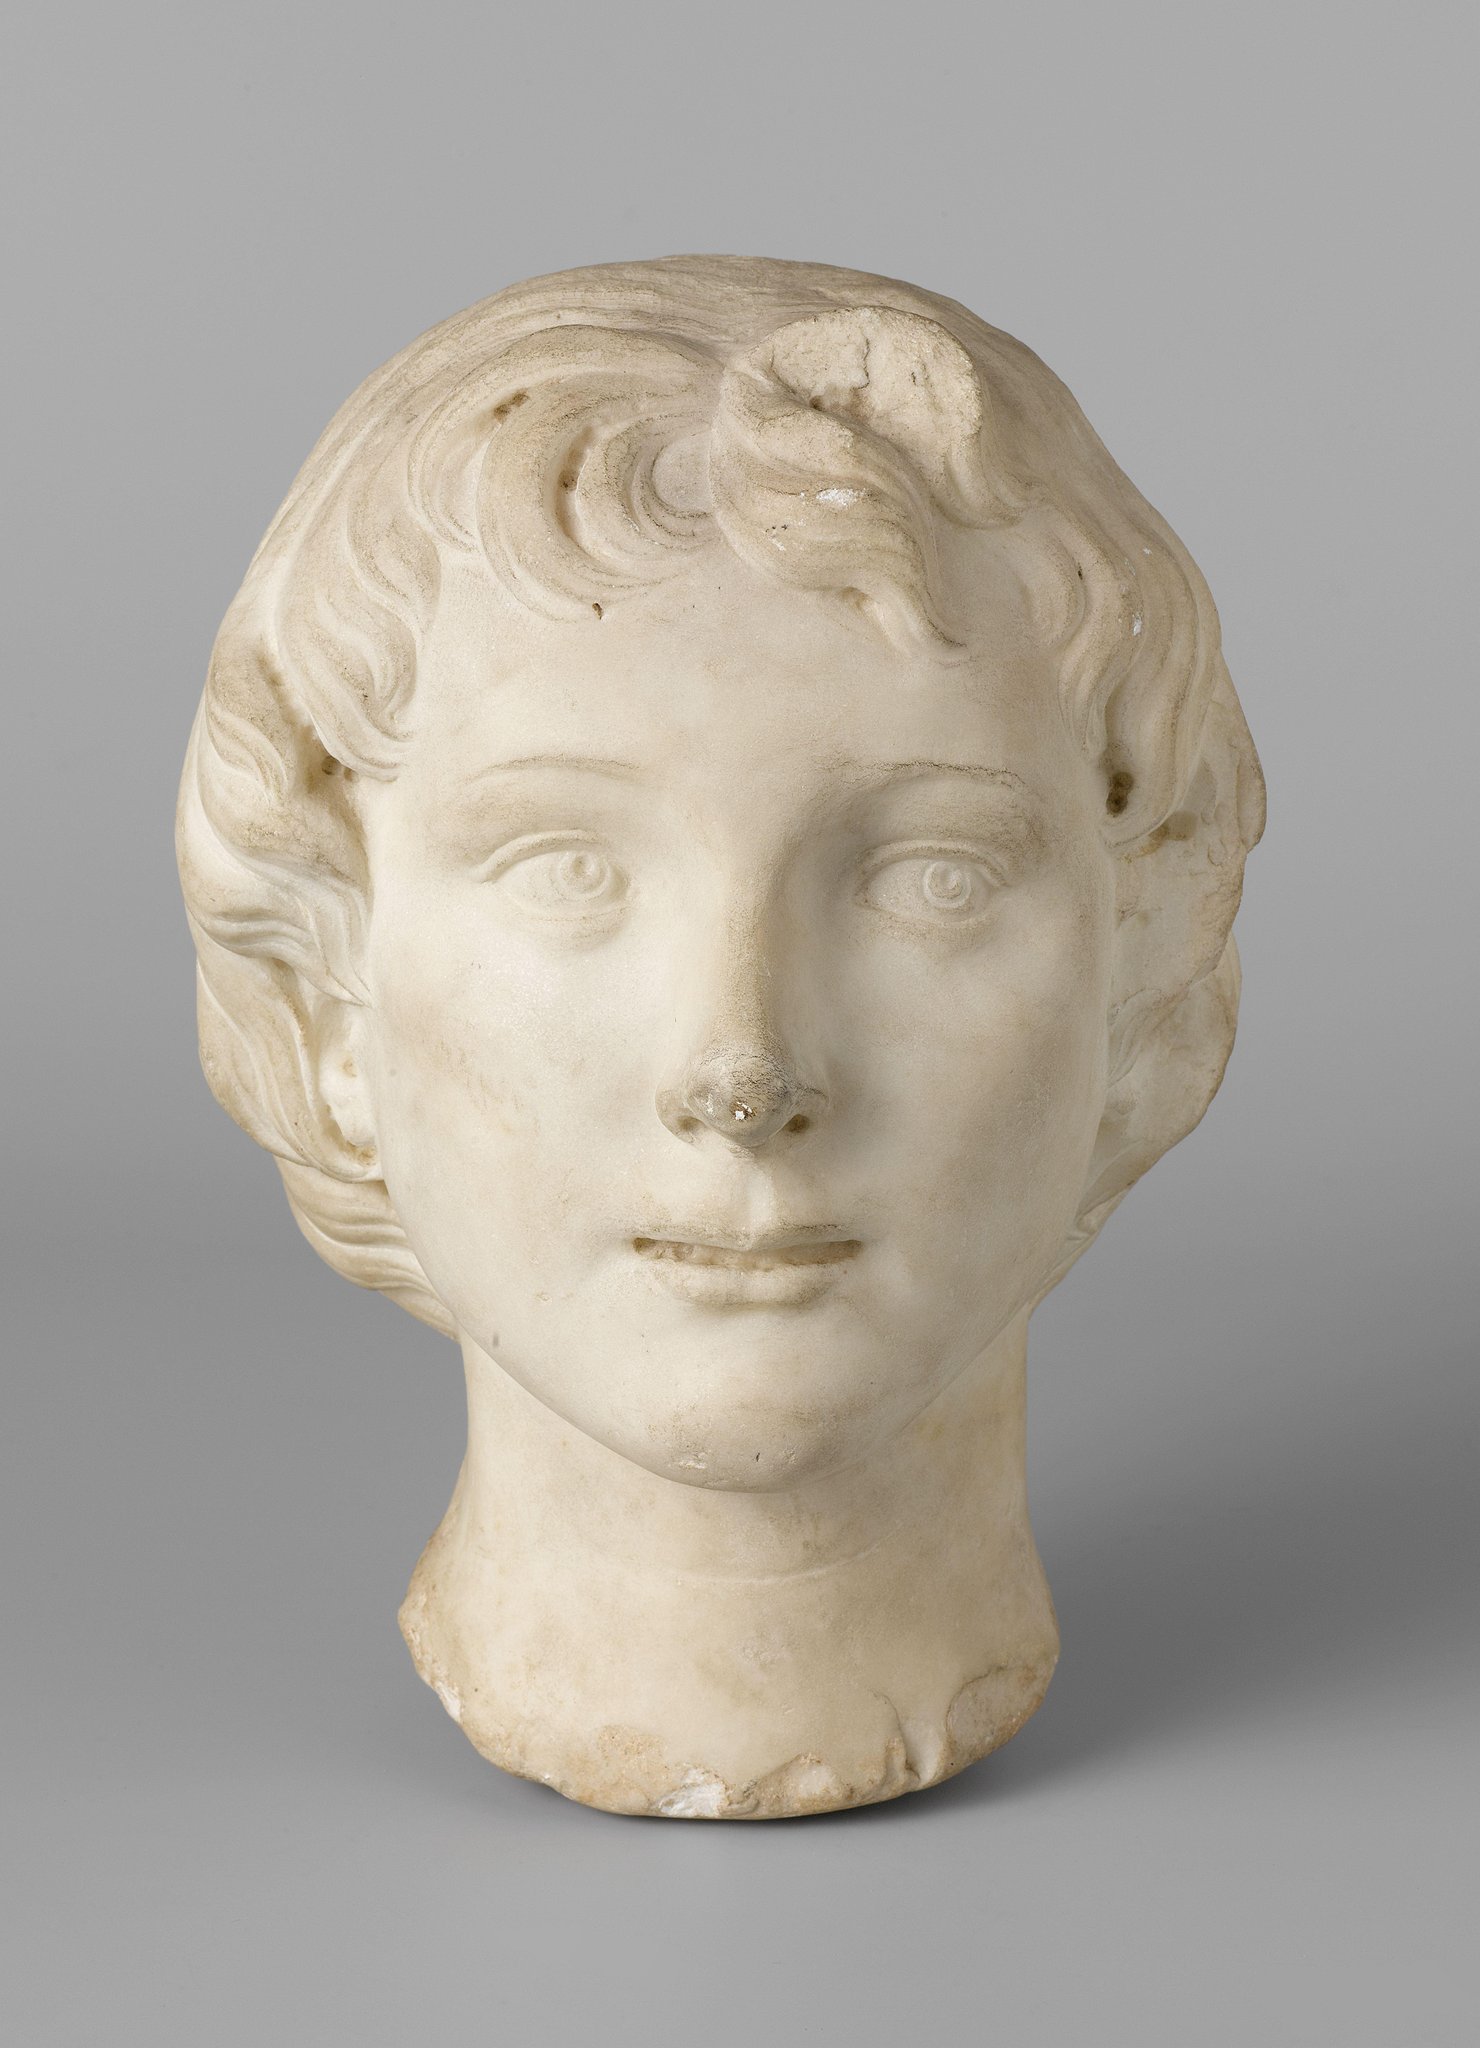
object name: sculpture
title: Kop van Johannes de Doper (vervalsing)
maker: Anonymous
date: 1850-1900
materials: marble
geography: florence